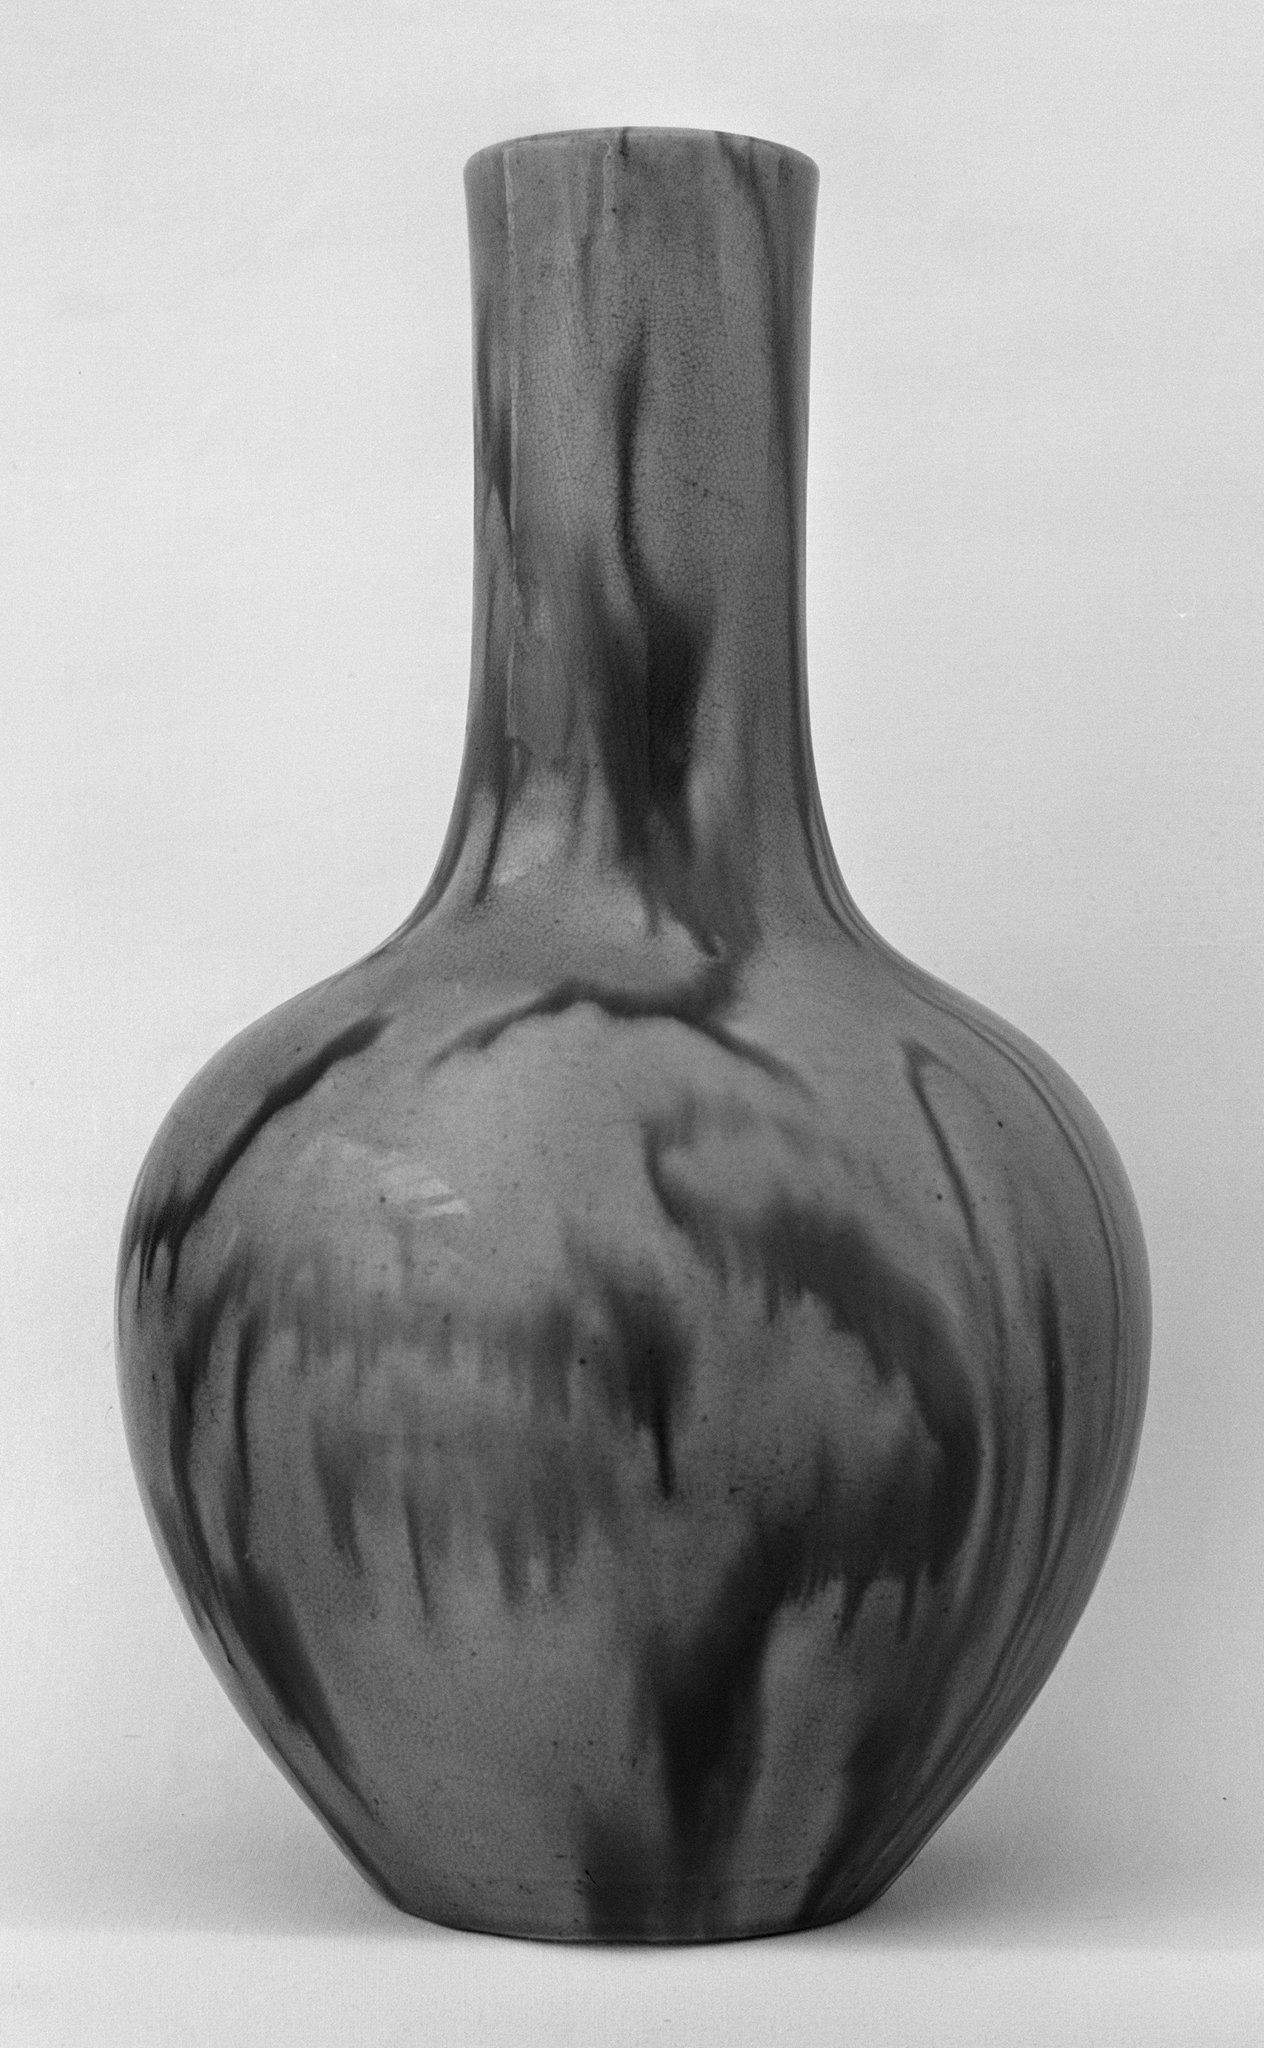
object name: bottle vase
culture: chinese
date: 1701-1800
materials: glaze, porcelain